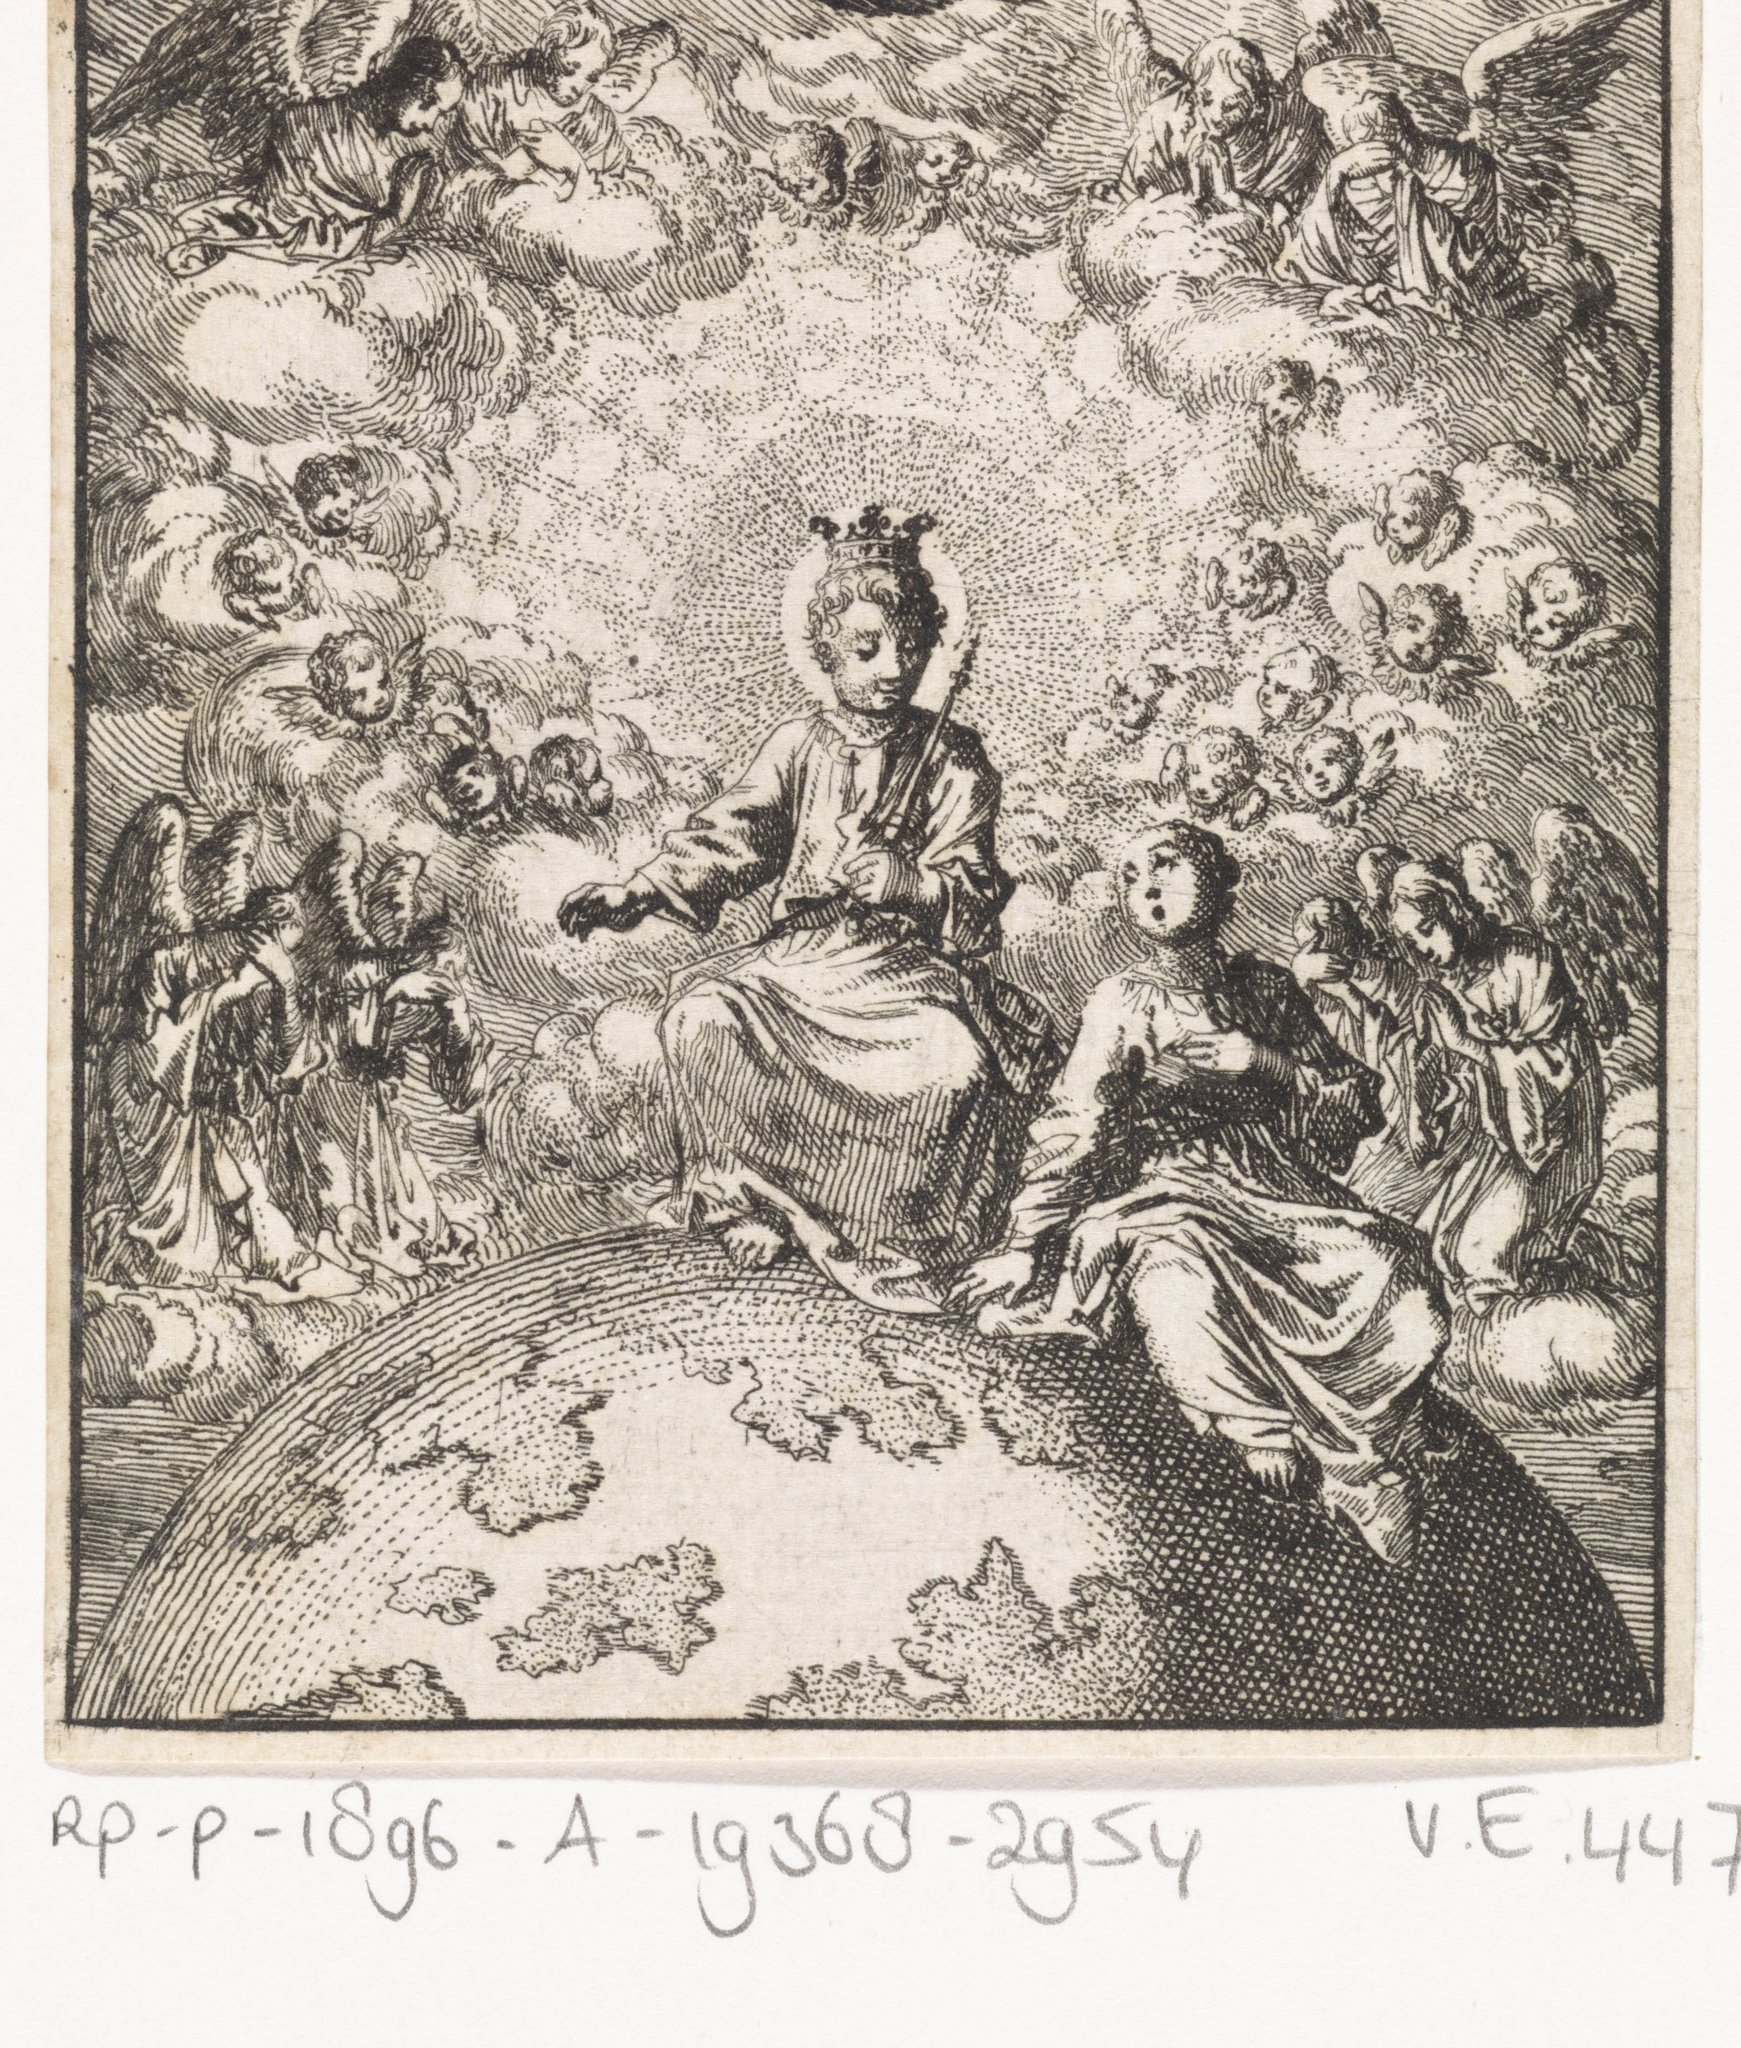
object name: print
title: Christus en de gepersonifieerde ziel door engelen omgeven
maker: jan luyken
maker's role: draughtsman, print maker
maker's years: 1649-1712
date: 1714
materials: paper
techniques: etching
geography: amsterdam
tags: the soul, christ and the soul, activities of angels (in heaven)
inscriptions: collector's mark: Lugt 2228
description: Proefdruk van illustratie uit: Luyken, Jan. Jezus en de Ziel, 3 delen. Amsterdam: Wed. Pieter Arentsz II en Cornelis van der Sys, 1714, dl. III, p. 141.